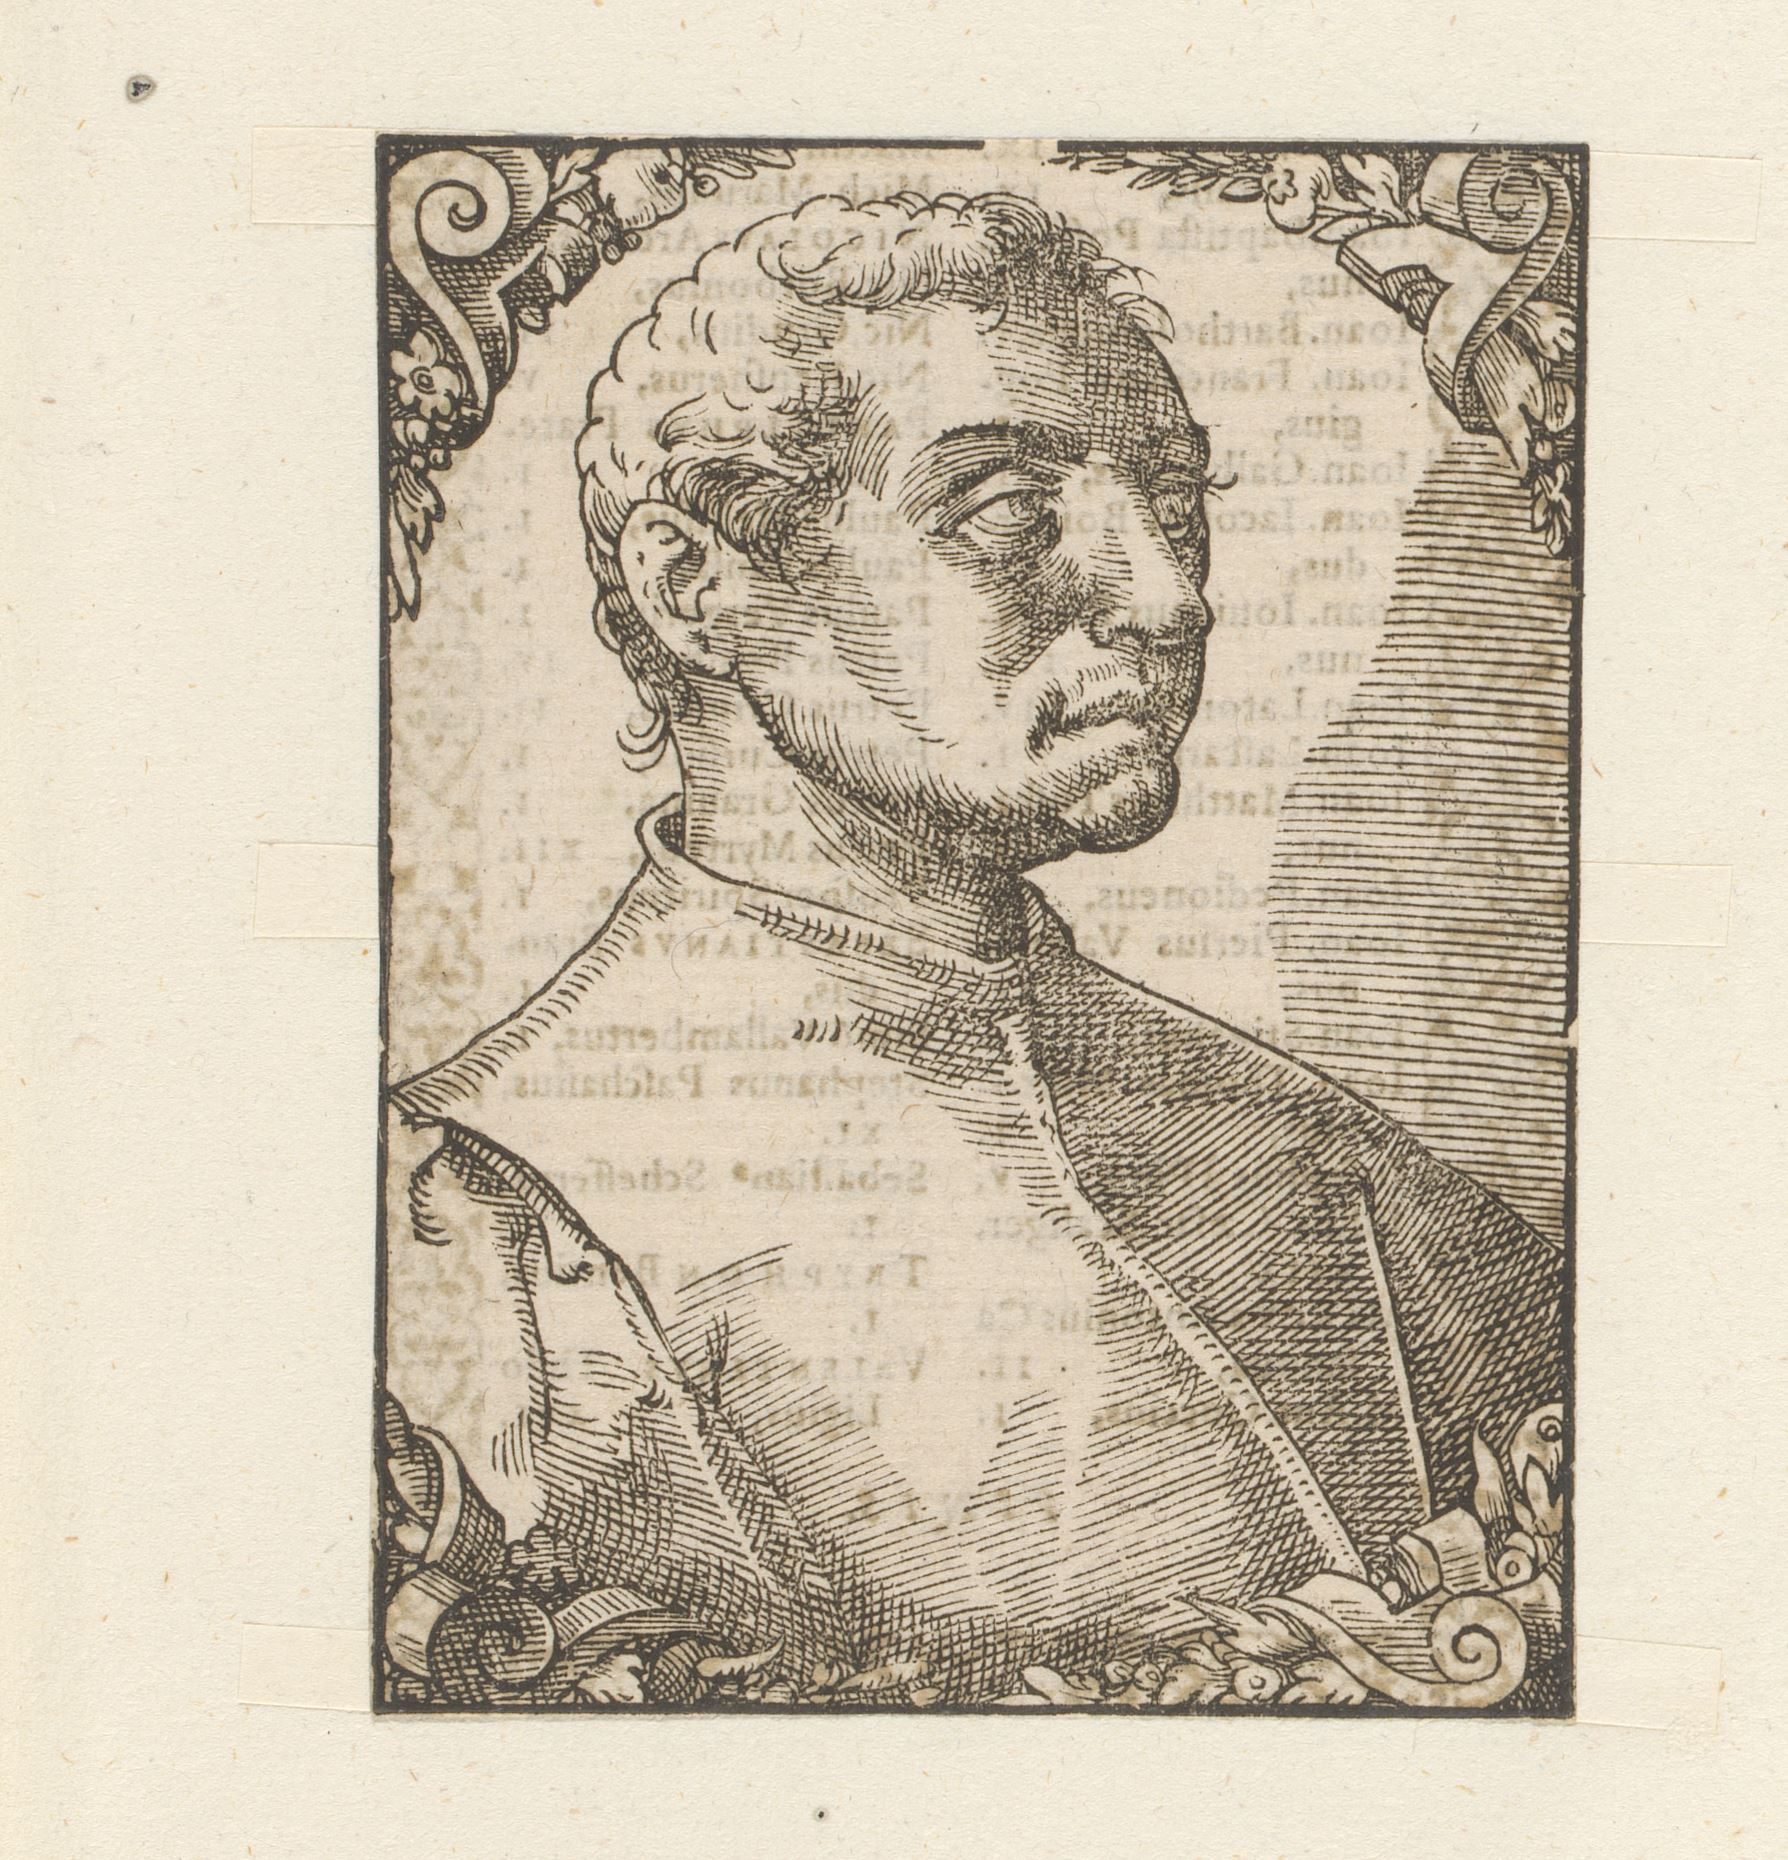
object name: book illustration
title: Portret van Giovanni Mario Cattaneo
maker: Anonymous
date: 1549-1577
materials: paper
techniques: letterpress printing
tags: philology (+ portrait of scholar, scientist), historical persons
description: Prent gebruikt in: Giovio, Paolo. Elogia Virorum literis illustrium (...). Bazel: Peter Perna, 1577.